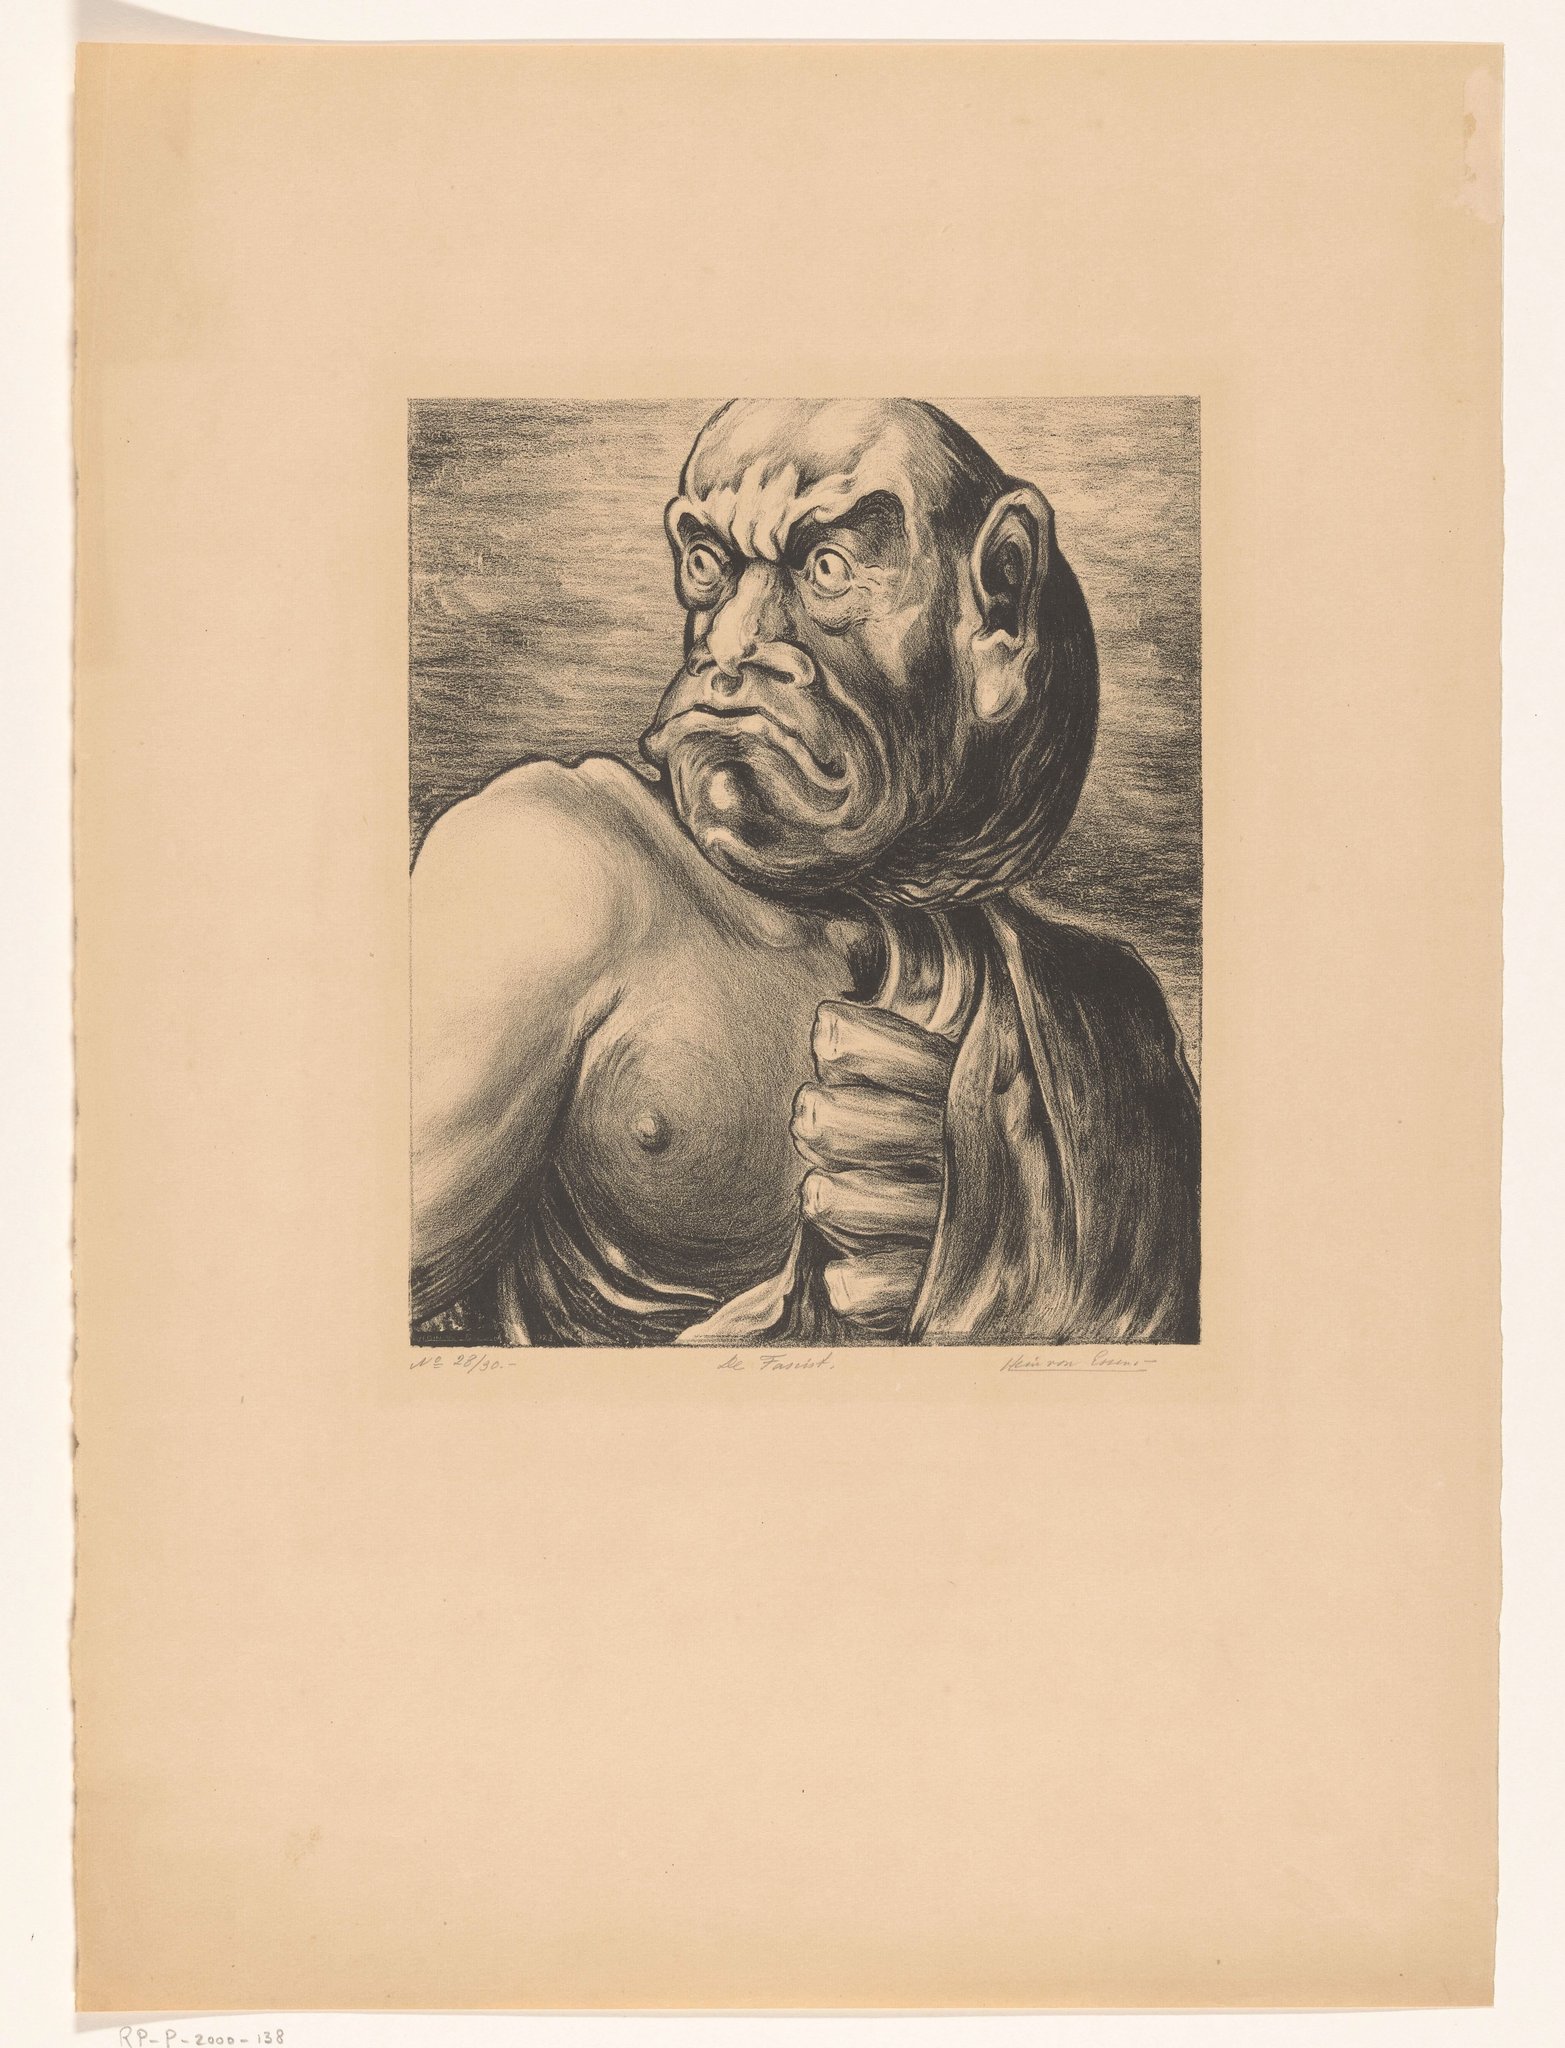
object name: print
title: De fascist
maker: hein von essen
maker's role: print maker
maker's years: 1886-1947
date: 1896-1947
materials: paper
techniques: lithograph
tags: caricatures (human types)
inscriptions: collector's mark: Lugt 2228, collector's mark: Lugt 2760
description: Karikatuur van een man, waarschijnlijk Benito Mussolini.